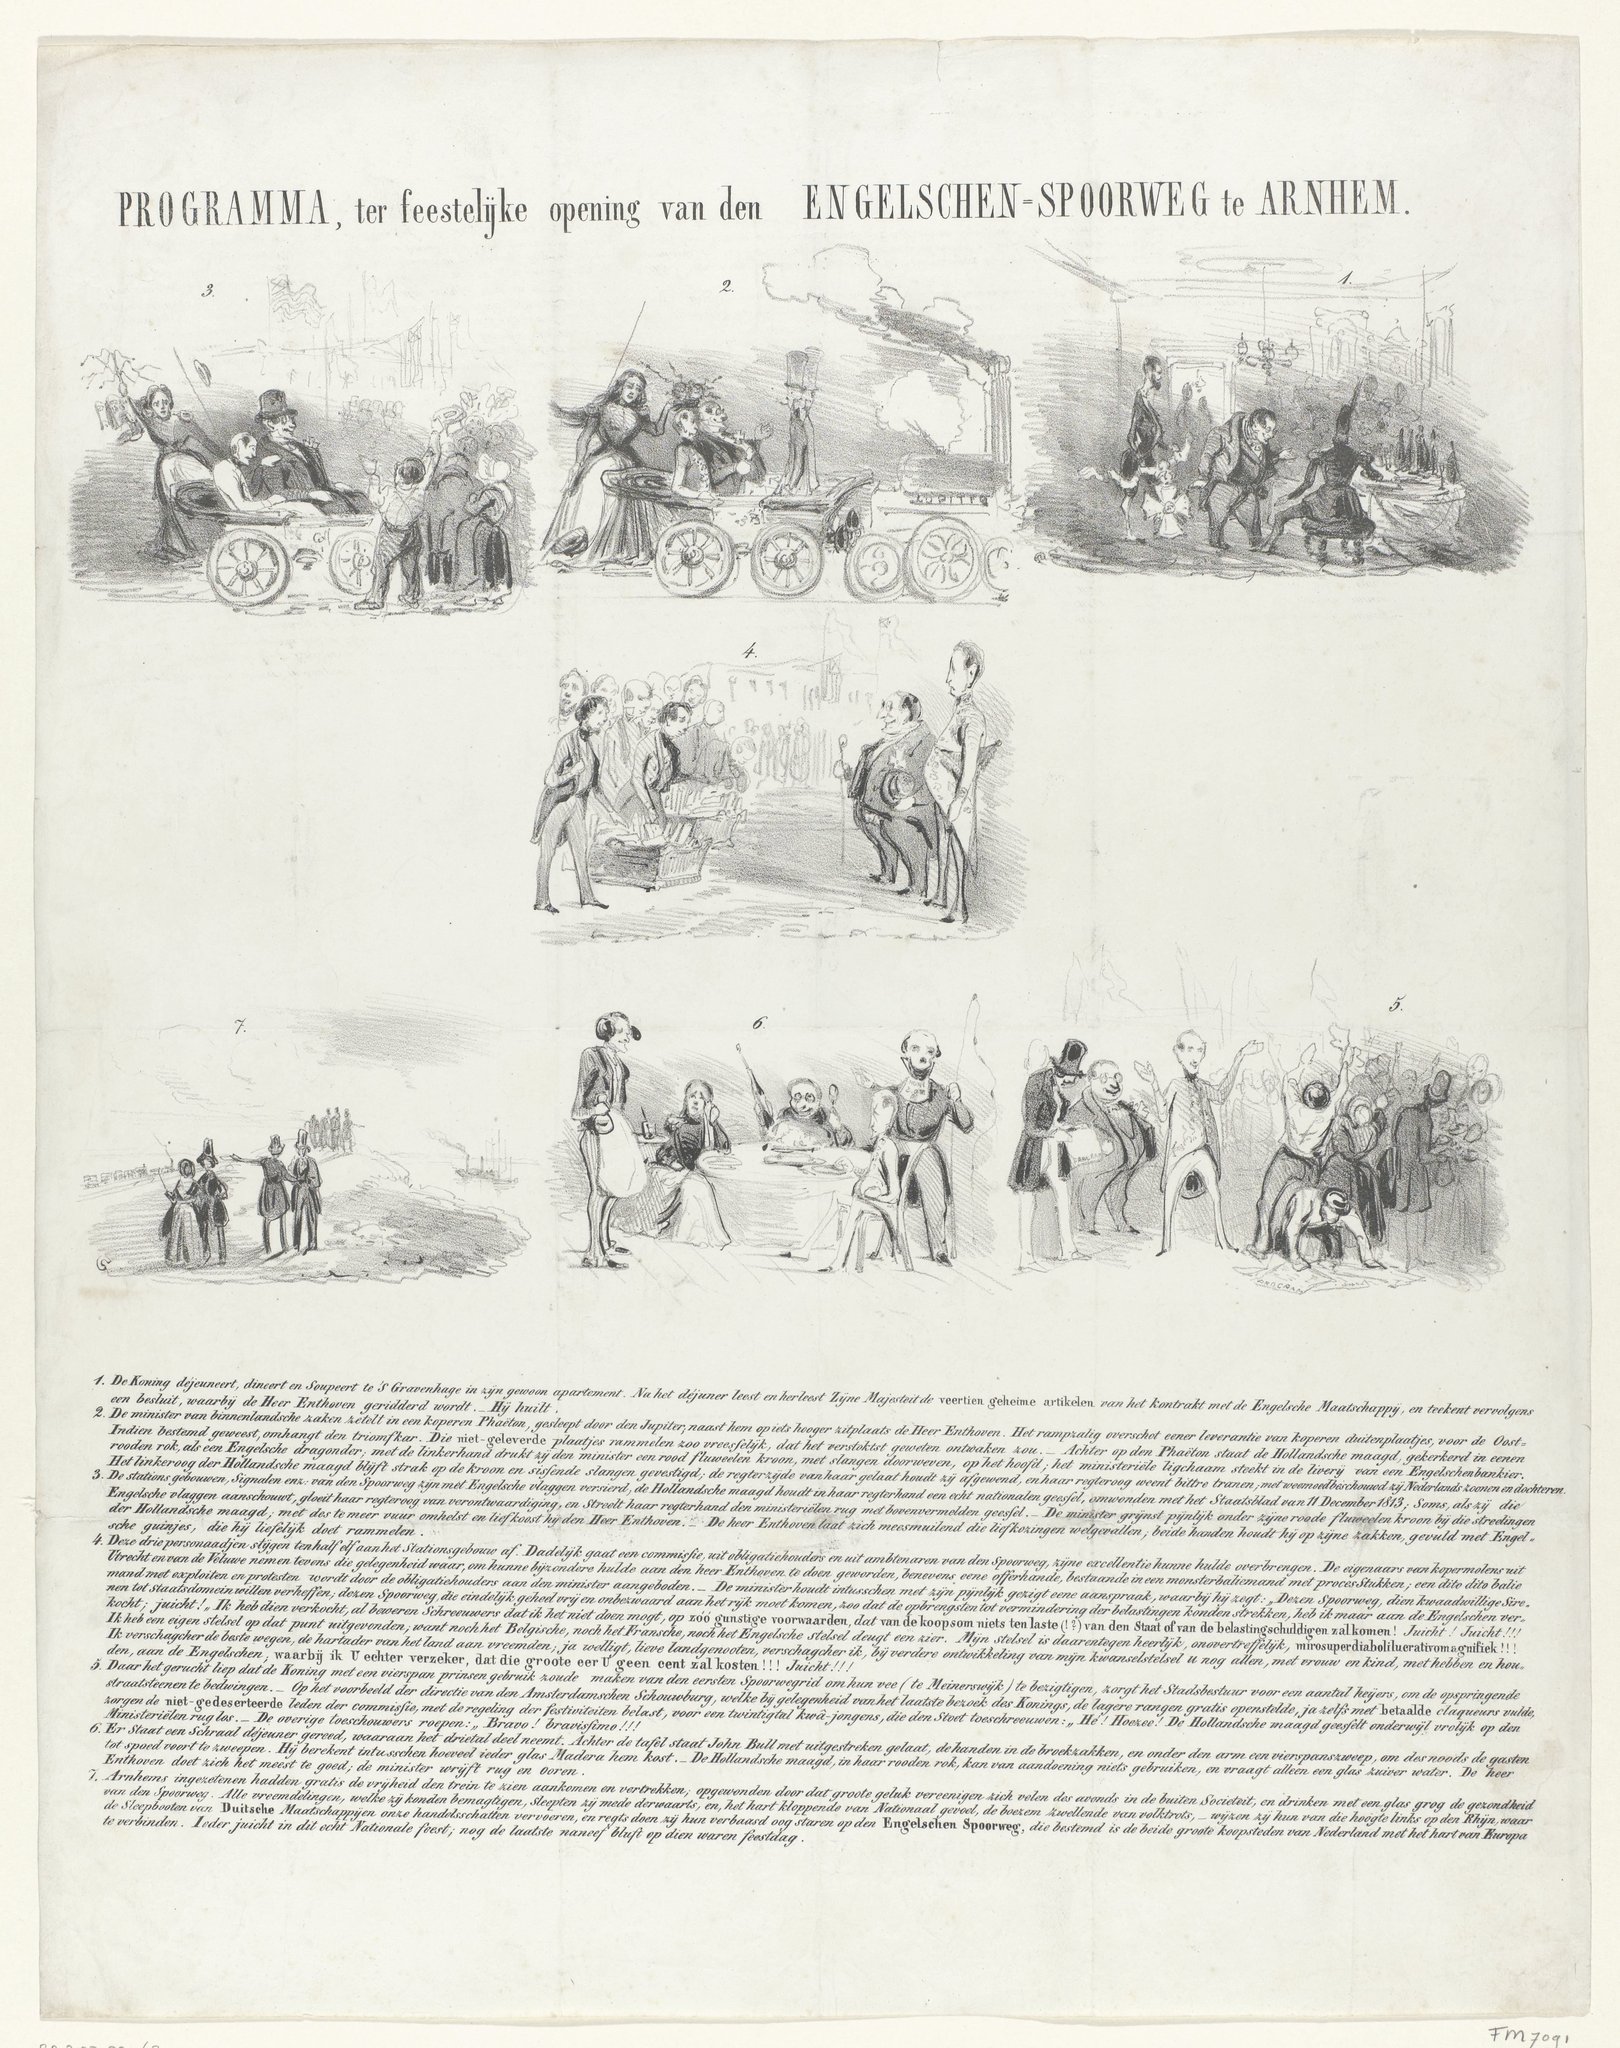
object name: cartoon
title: Spotprent op het contract voor de Rhijnspoorweg verbinding met Arnhem, 1845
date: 1845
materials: paper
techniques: lithograph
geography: arnhem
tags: railway, train (+ propulsion of vehicle, ship, etc. by steam), arnhem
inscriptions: collector's mark: Lugt 2228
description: Spotprent op het contract gesloten door minister Schimmelpenninck van der Oye en de heer Enthoven voor de verbinding van de Rhijnspoorweg met Arnhem, mei 1845. het contract was voordelig voor de Engelse aandeelhouders maar nadelig voor de Nederlandse. Blad met zeven kleine genummerde voorstellingen. onderaan de verklaring 1-7.